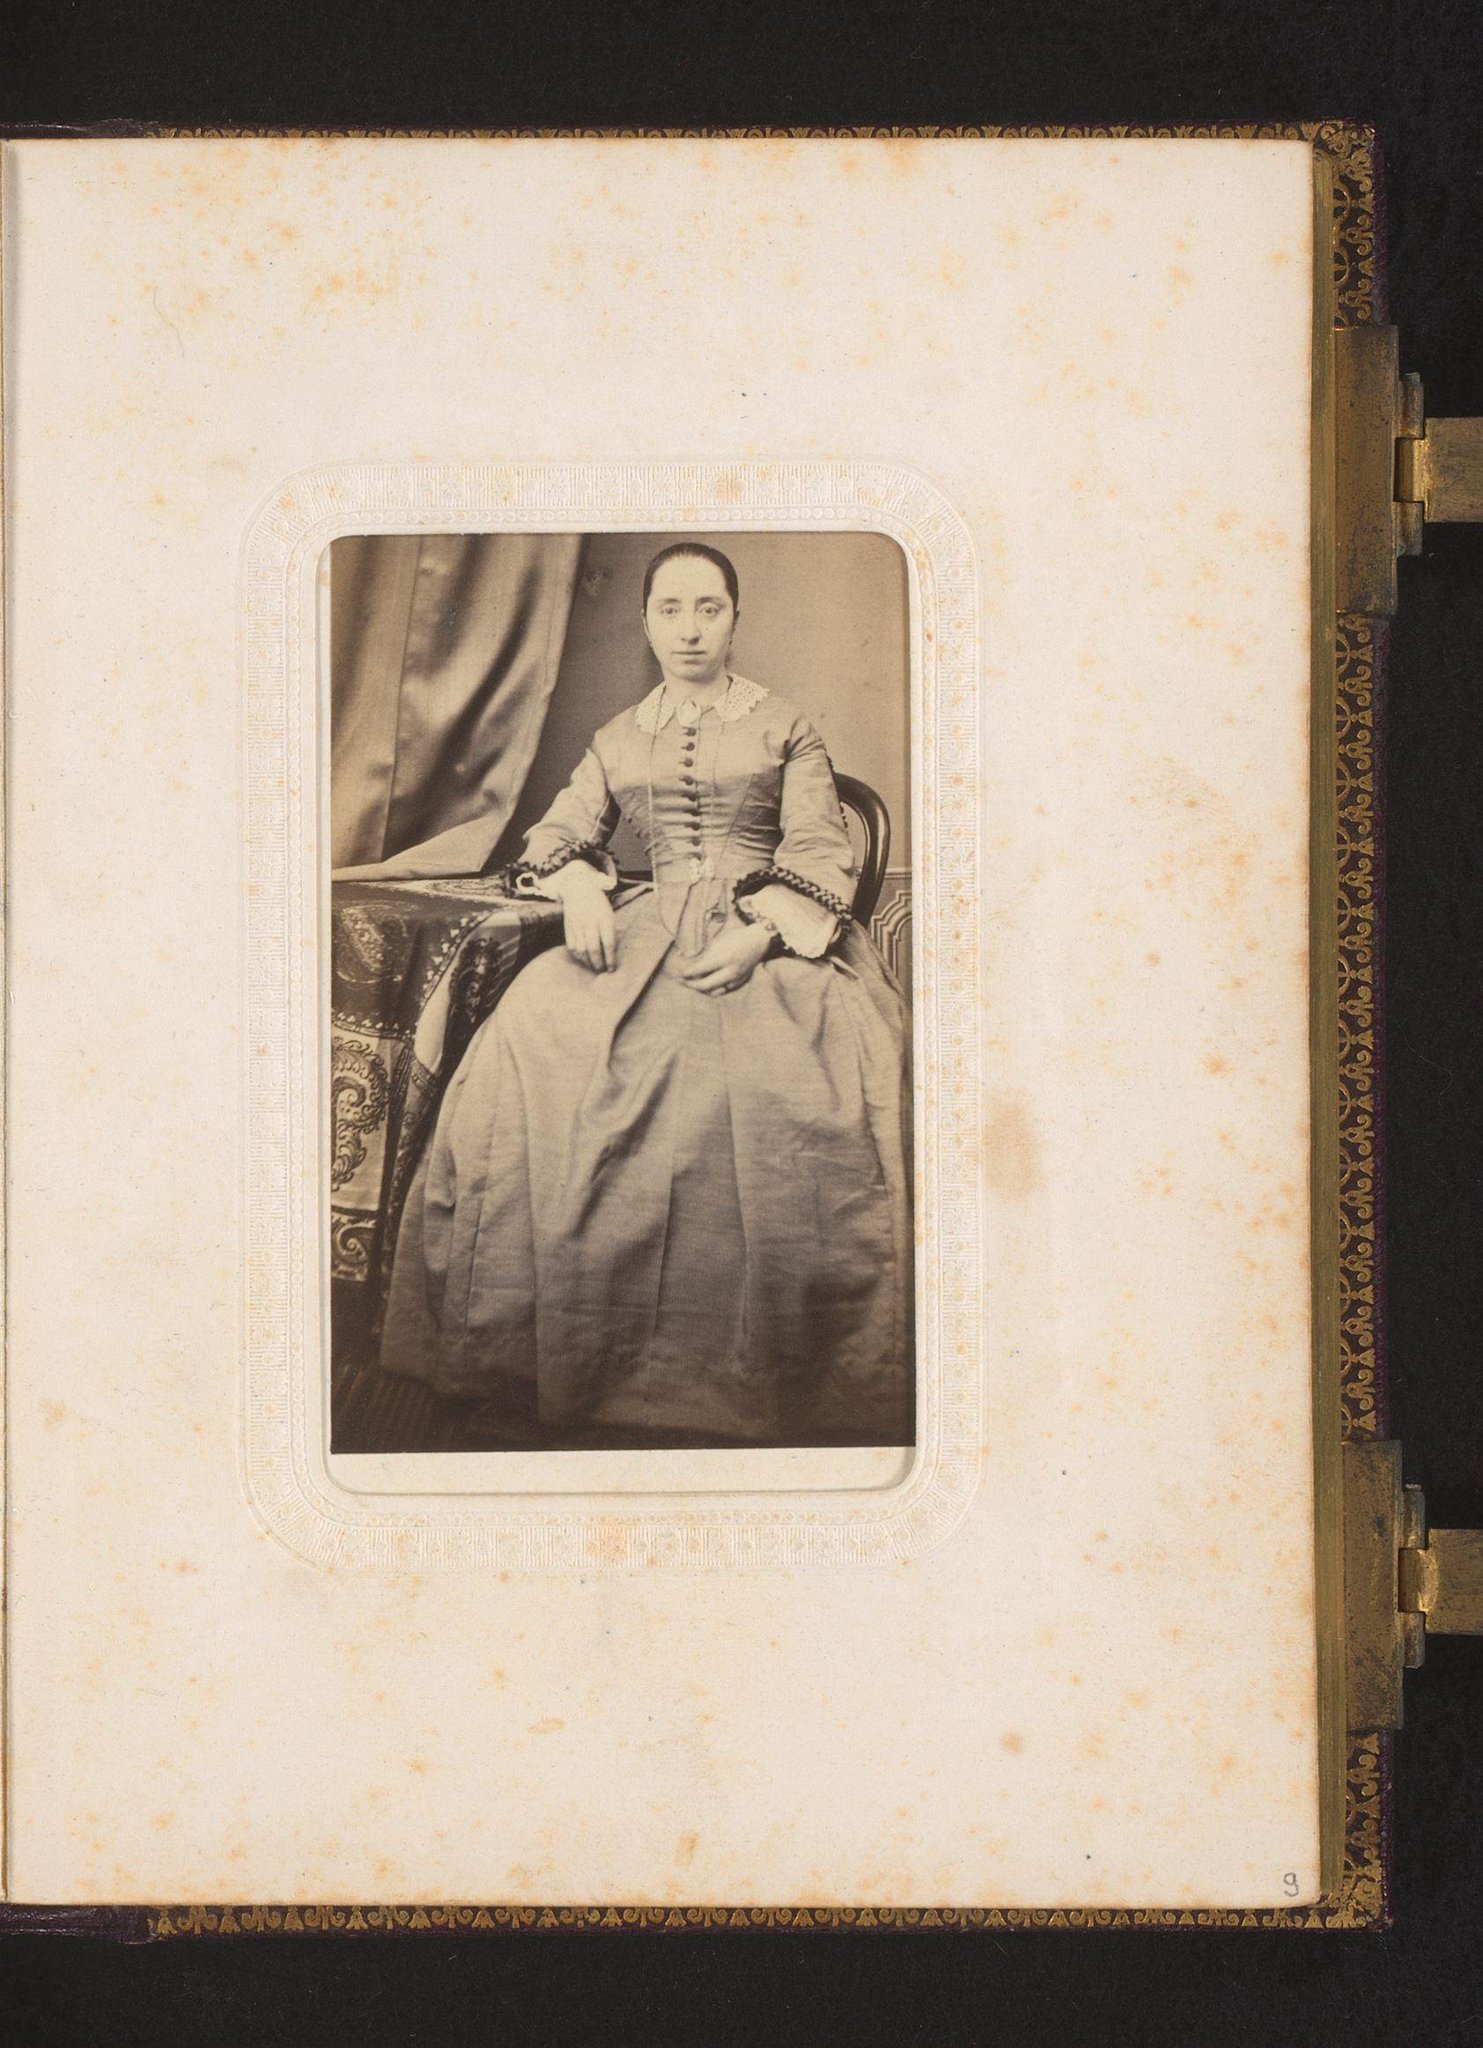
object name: album leaf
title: Portret van een vrouw, zittend aan een tafel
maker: Anonymous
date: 1860-1900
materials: cardboard, photographic support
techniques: albumen print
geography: france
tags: sitting figure - aa - female human figure, historical persons - bb - woman, table